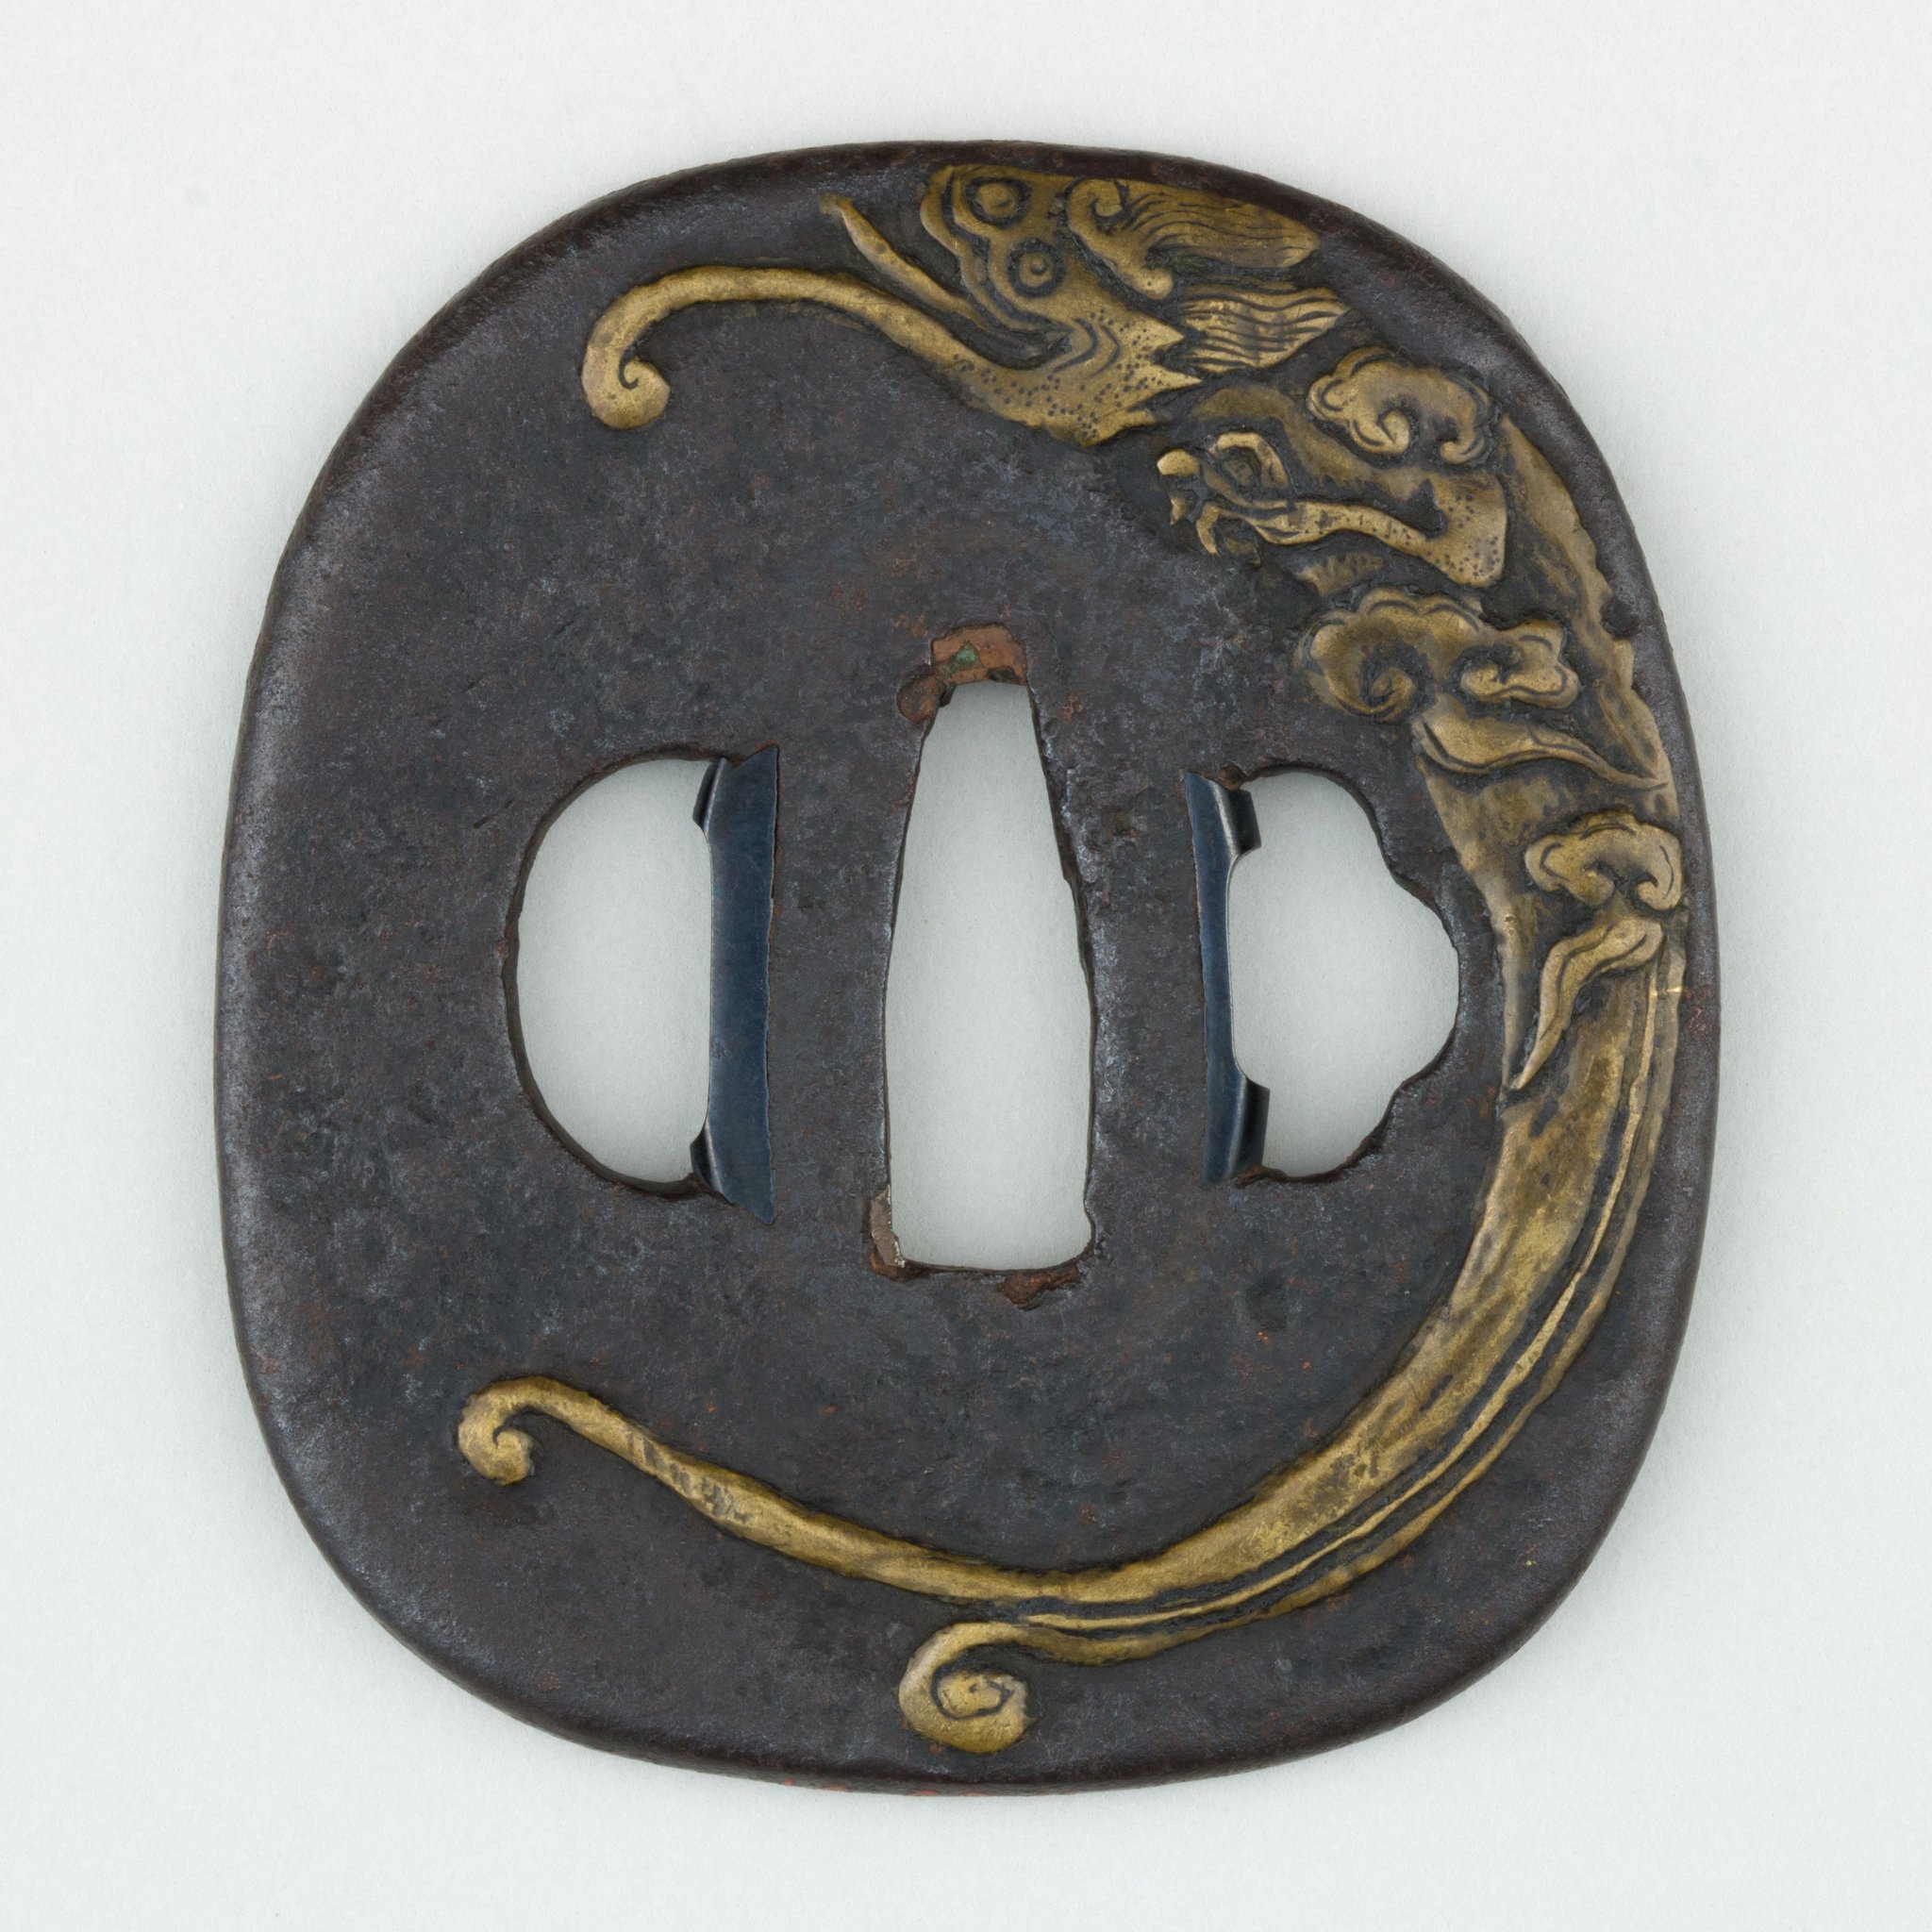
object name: sword guard tsuba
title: Sword Guard (Tsuba)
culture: japanese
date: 1601-1700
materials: bronze, copper, iron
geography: japan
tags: dragons